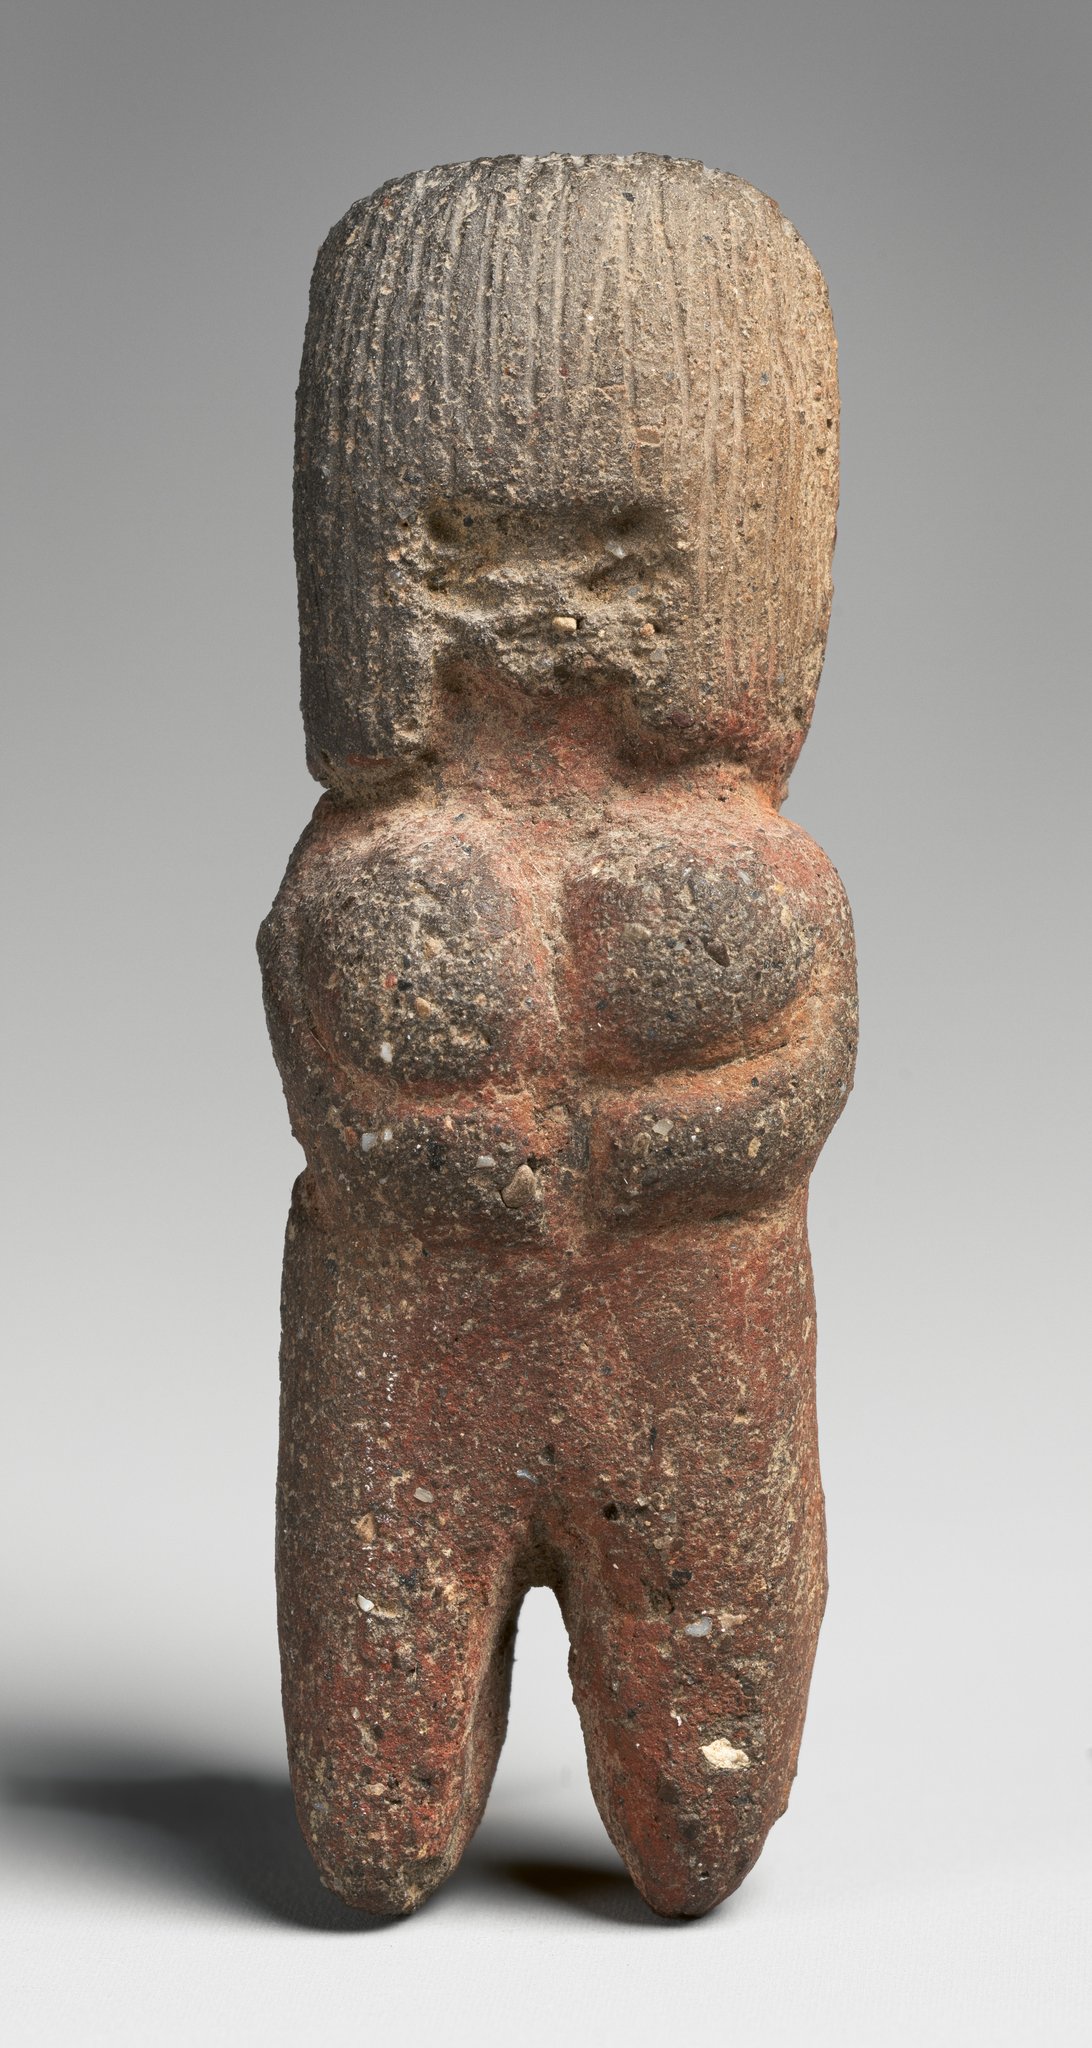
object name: female figure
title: Figure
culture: valdivia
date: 3000-2001 BCE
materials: ceramic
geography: ecuador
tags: female nudes